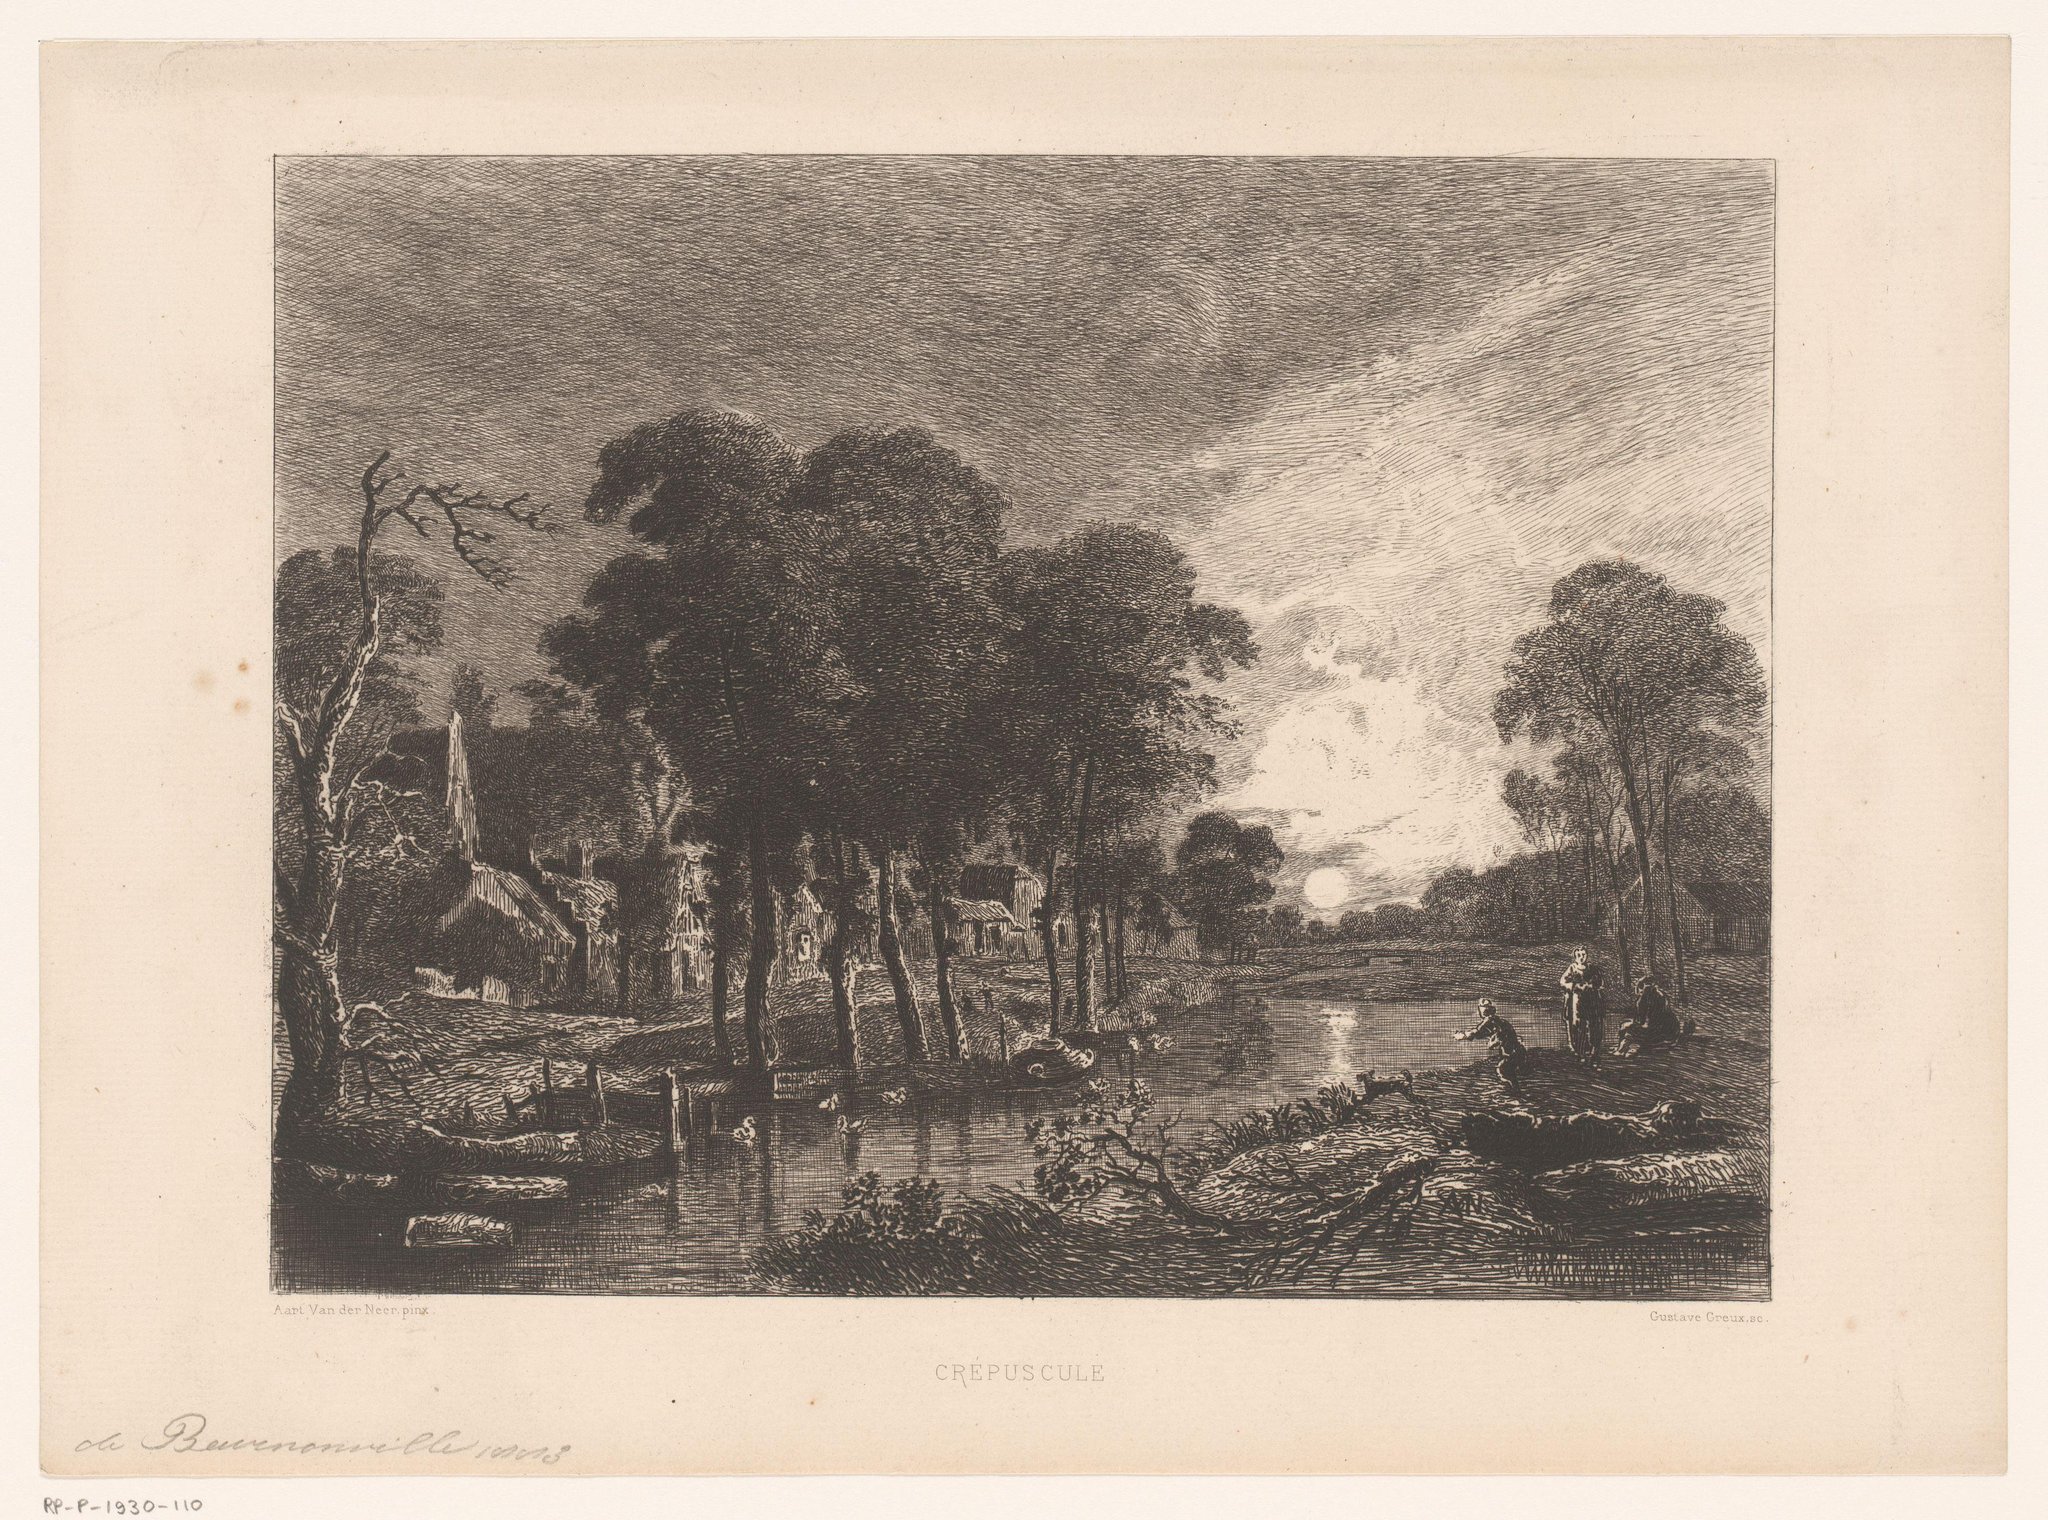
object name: print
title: Rivierlandschap bij maneschijn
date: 1848-1919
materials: paper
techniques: etching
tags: river, moonlight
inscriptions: collector's mark: Lugt 2228